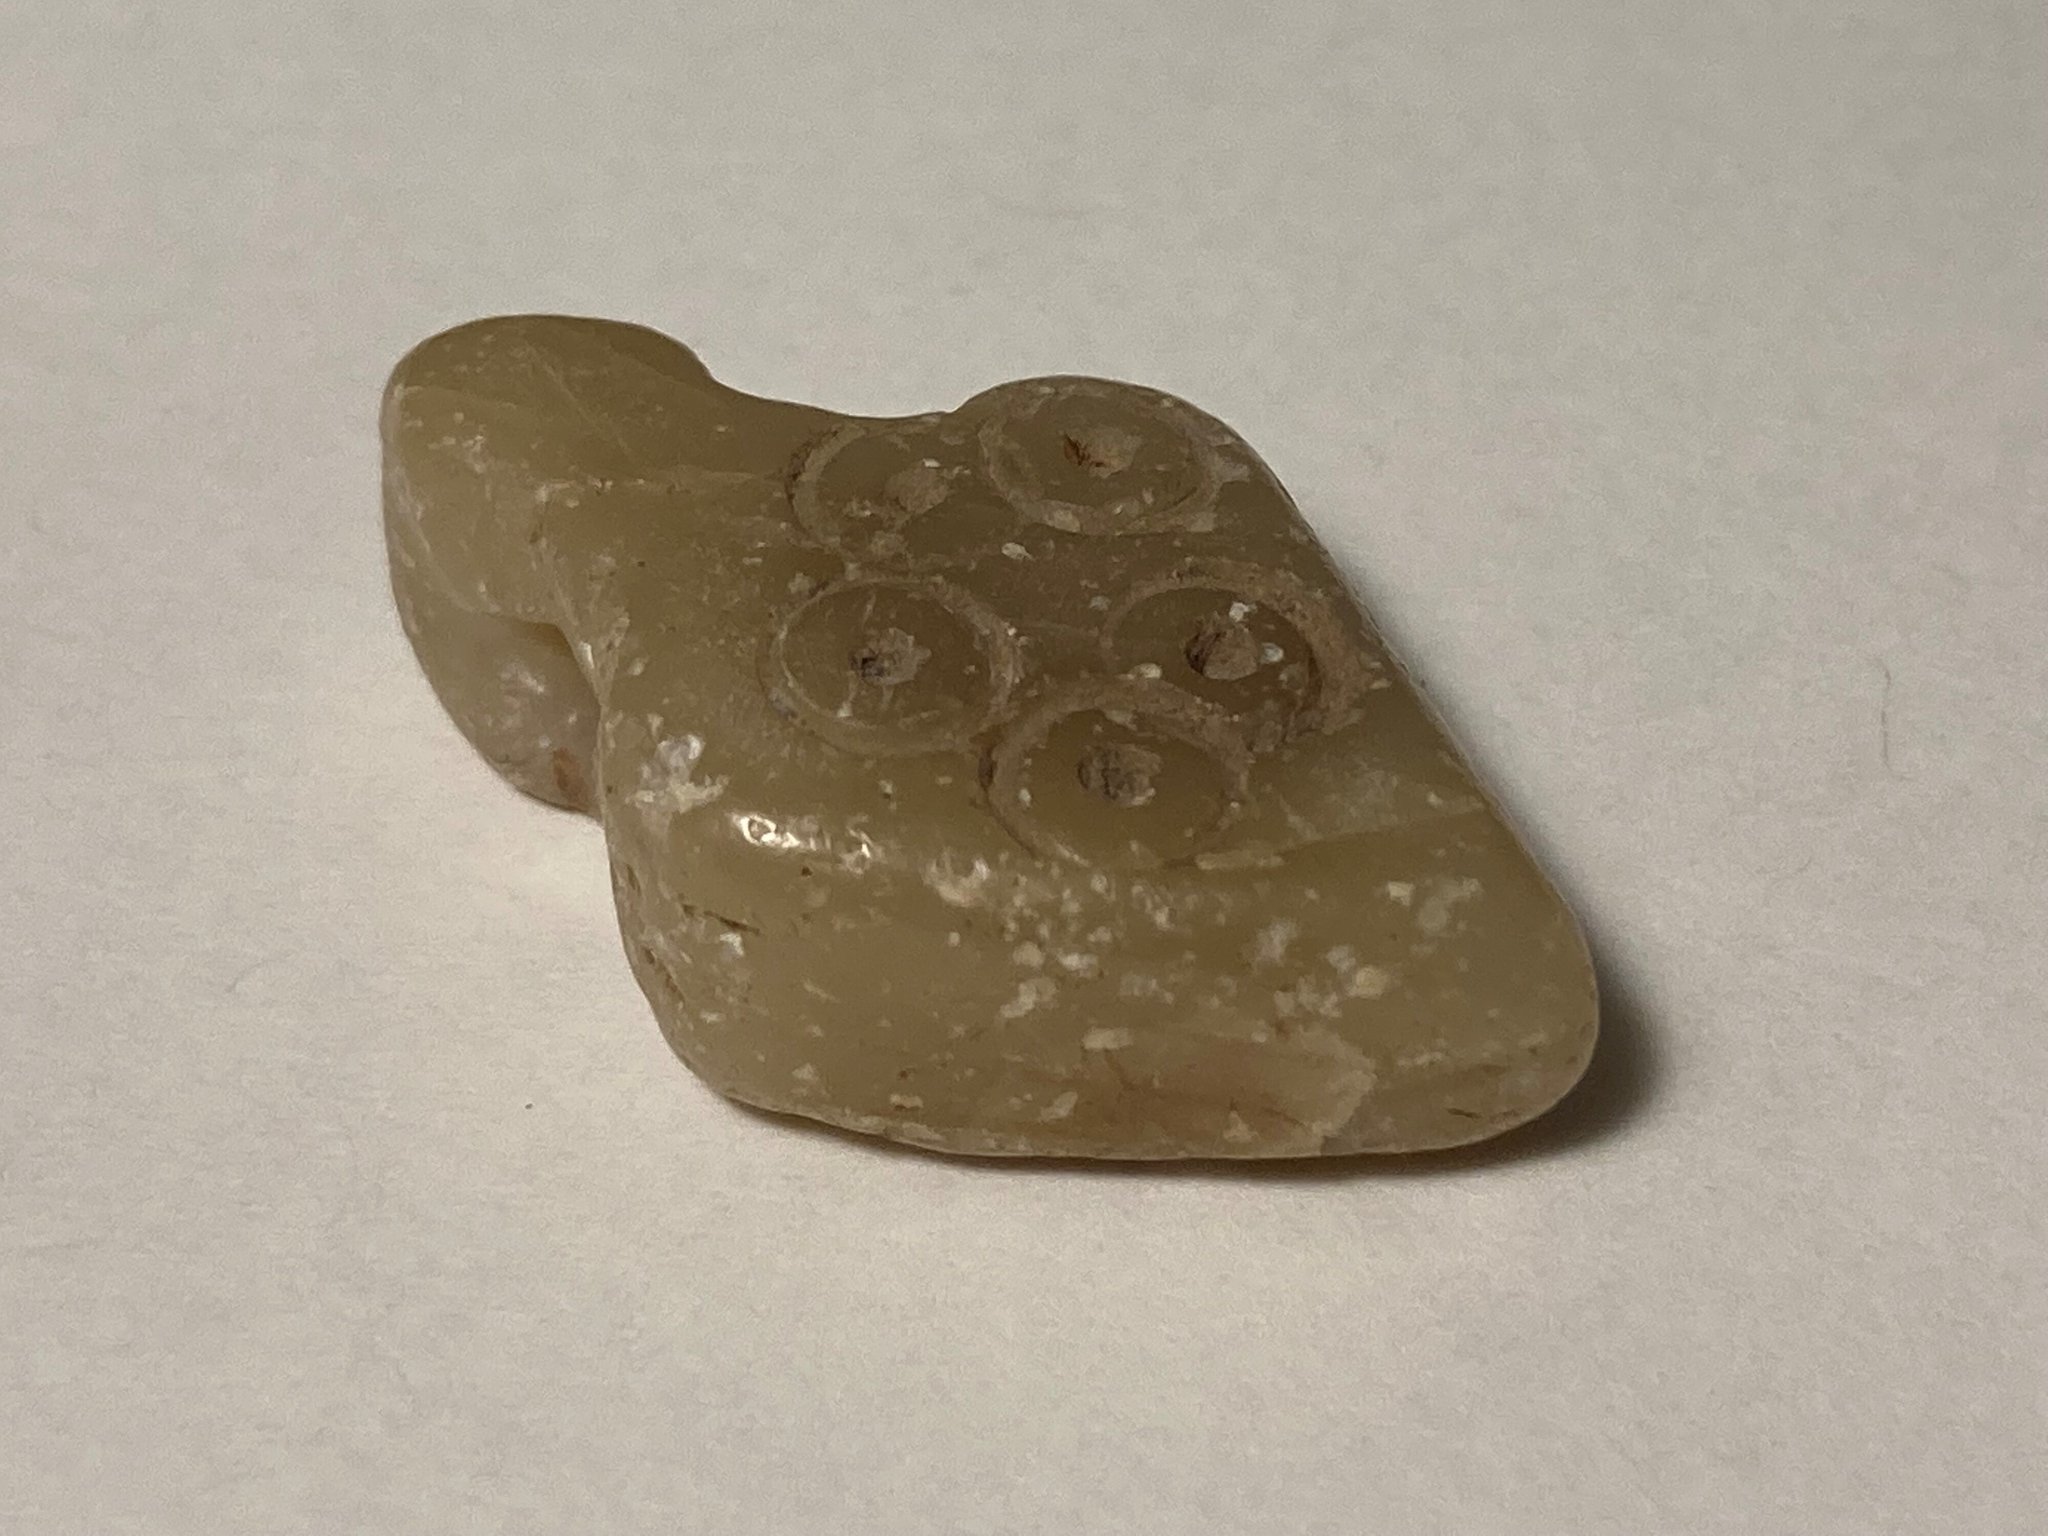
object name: bead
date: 701-1300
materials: stone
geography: iran